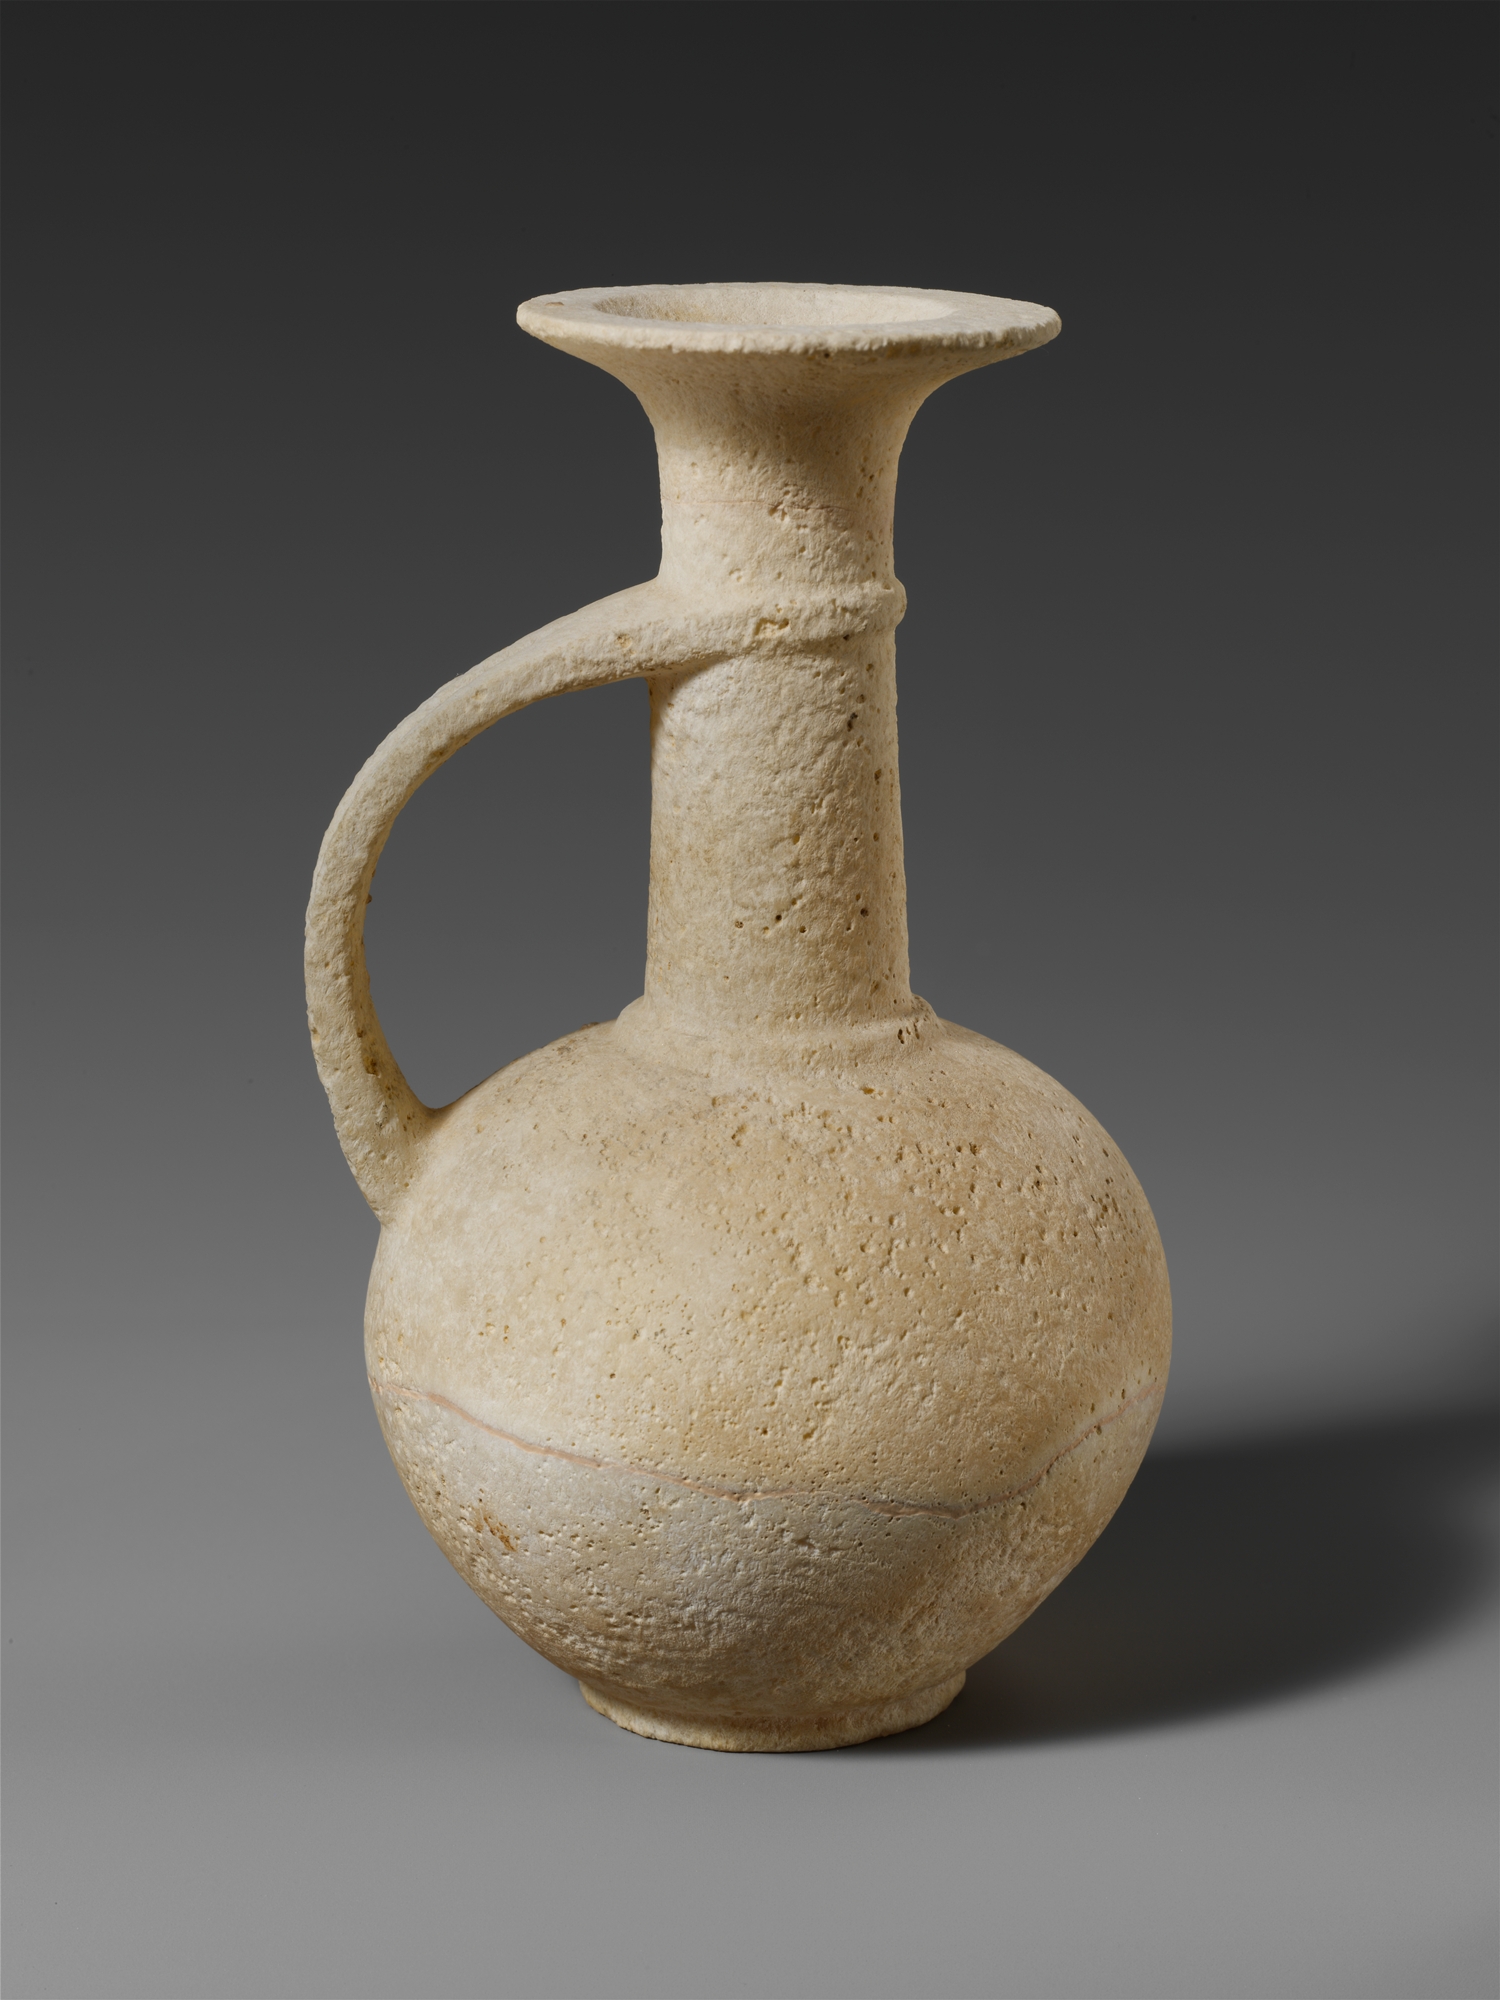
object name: jug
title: Alabaster jug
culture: cypriot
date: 1450-1200 BCE